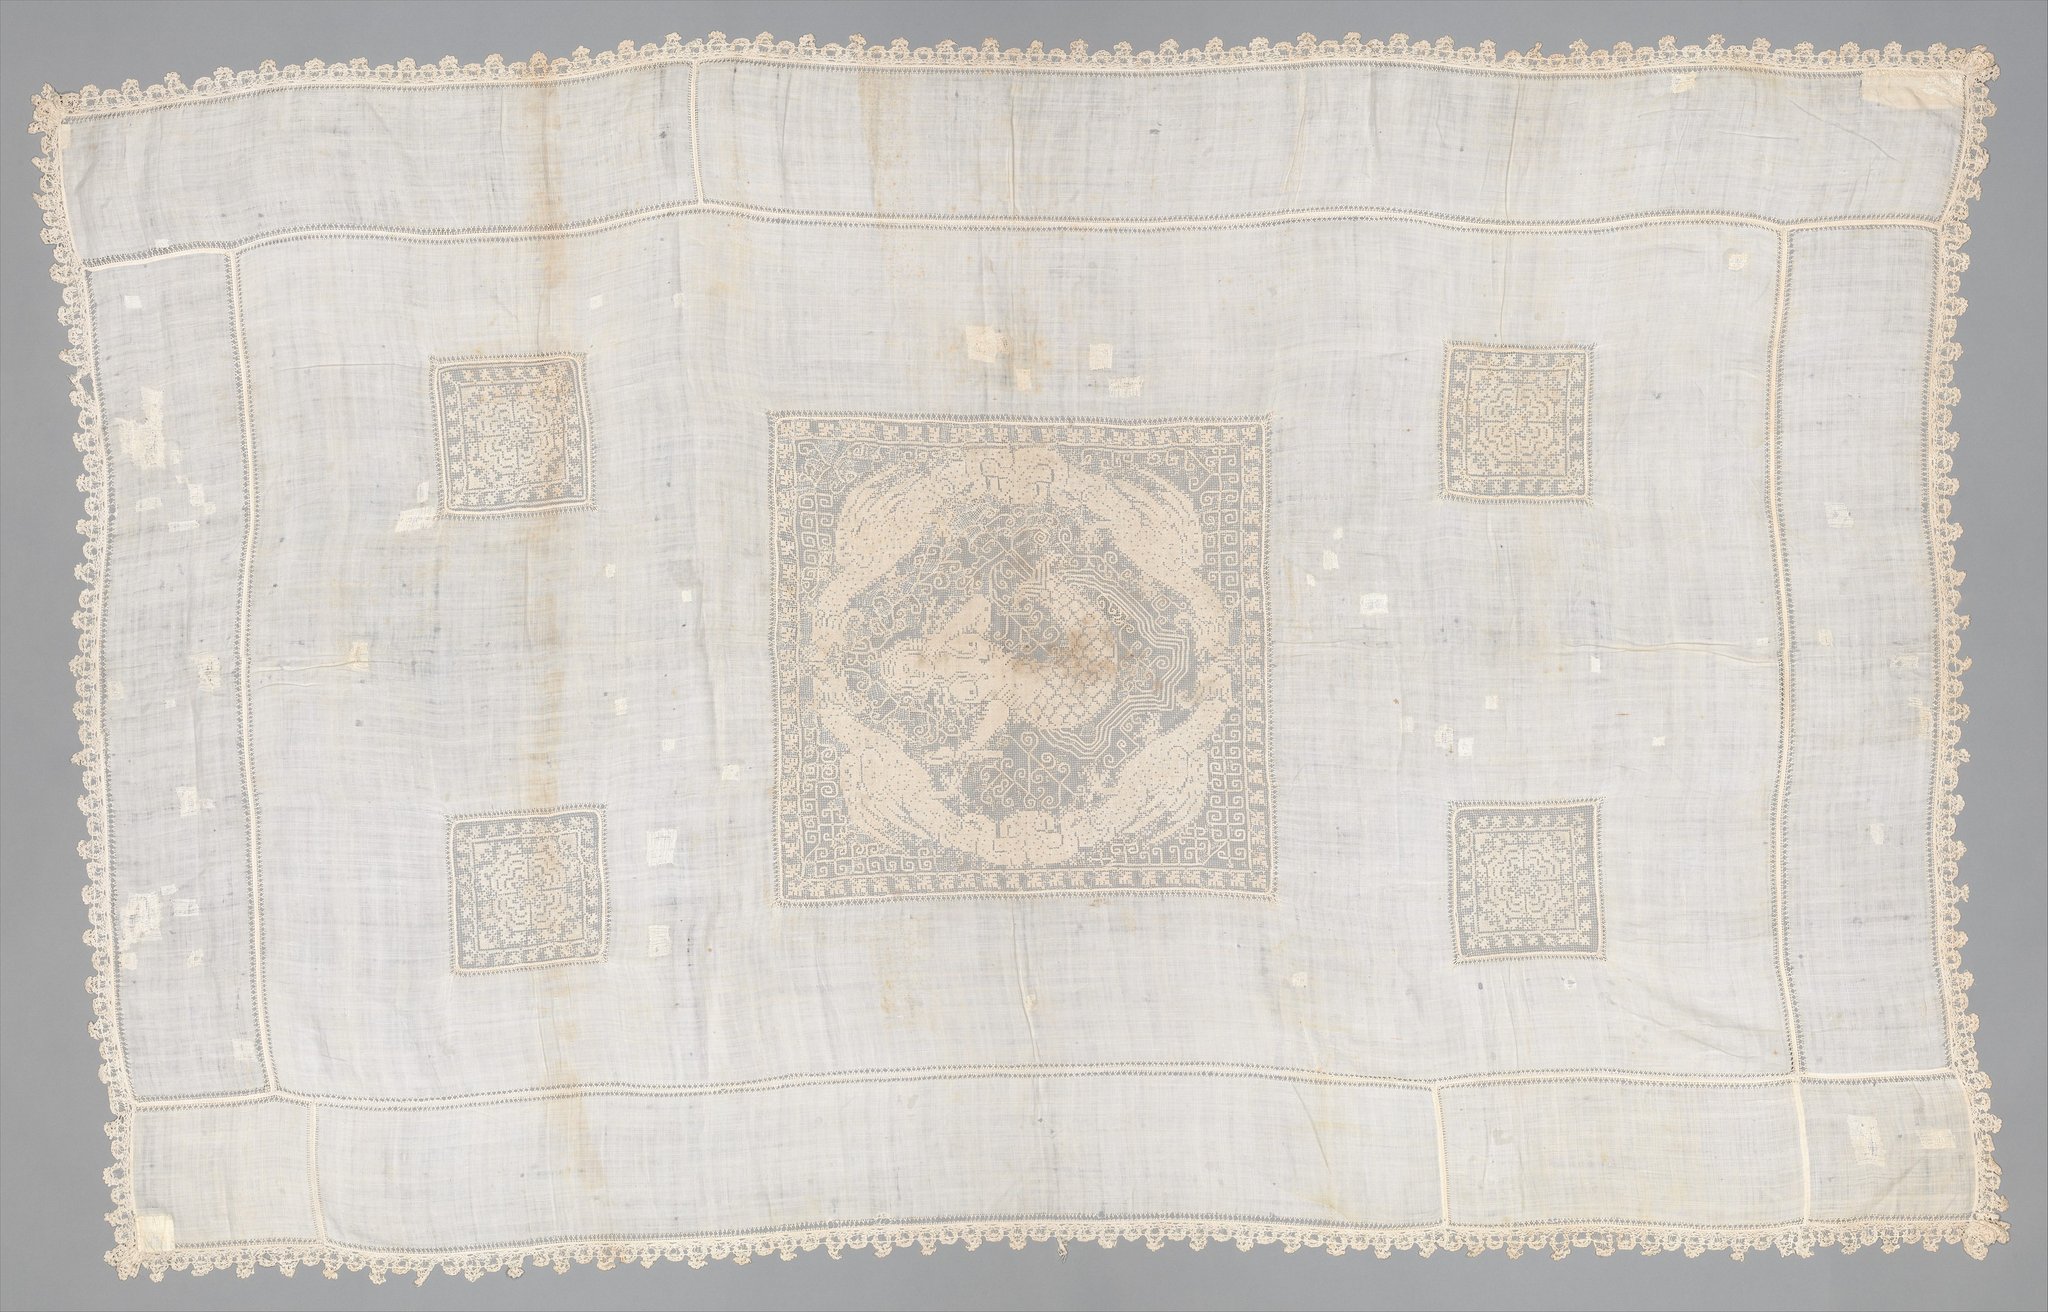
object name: table cover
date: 1501-1600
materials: linen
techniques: embroidery